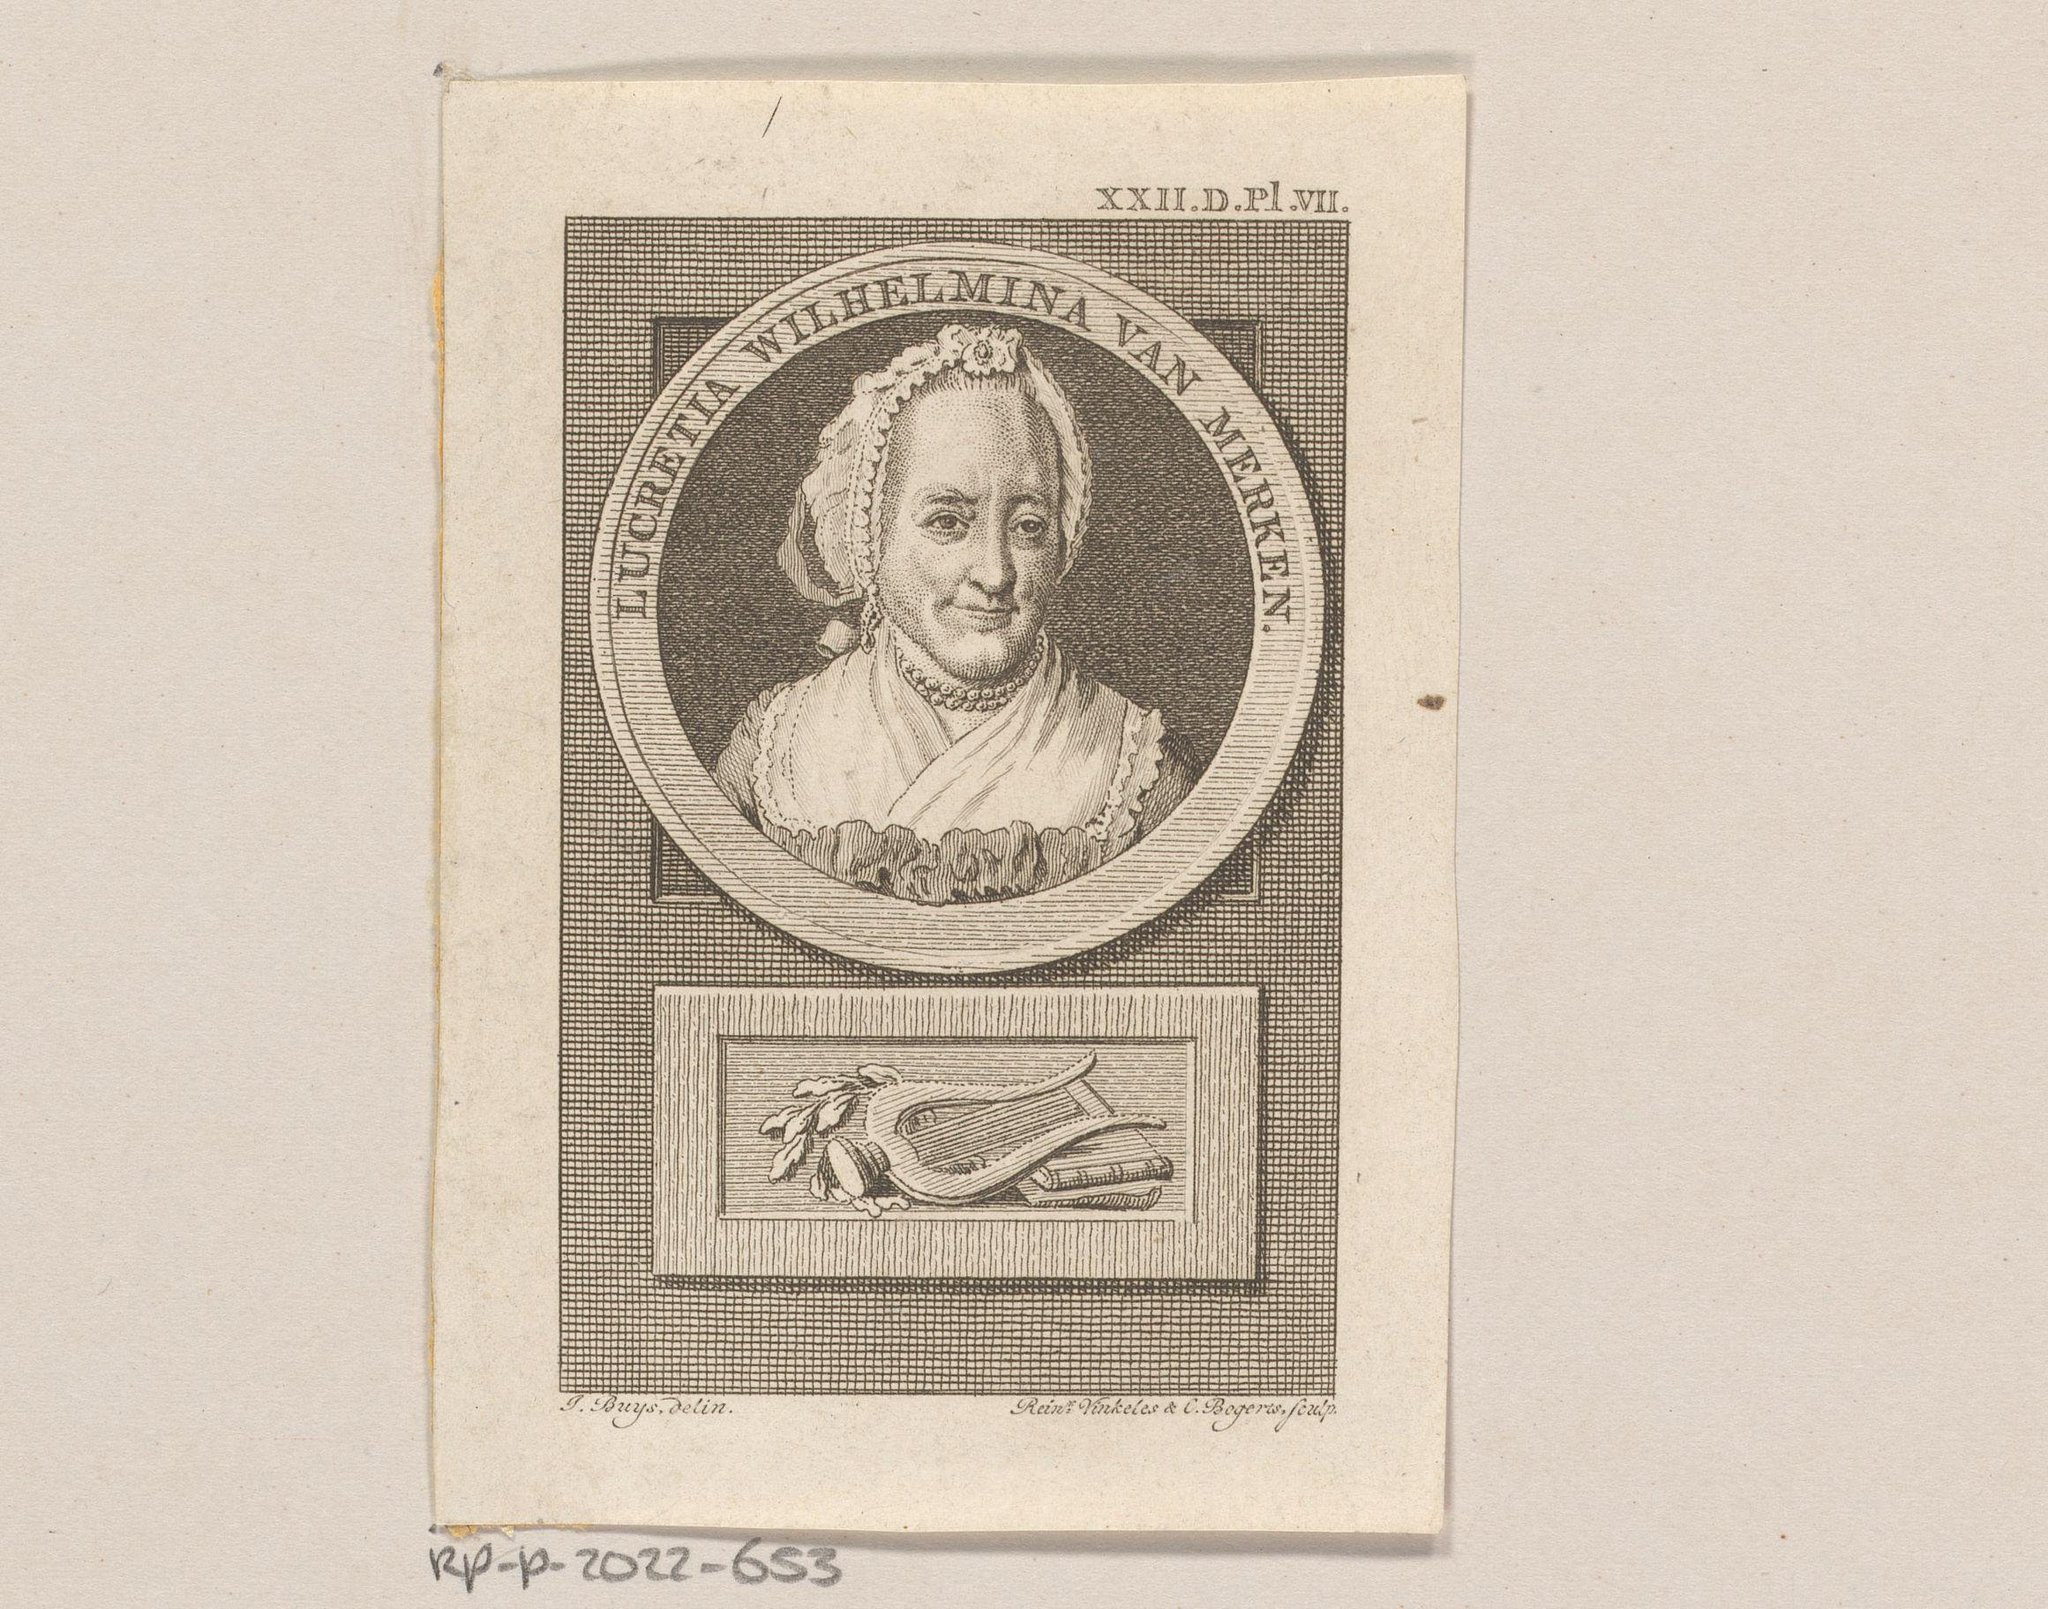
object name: print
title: Portret van Lucretia Wilhelmina van Merken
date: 1794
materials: paper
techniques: engraving, etching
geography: amsterdam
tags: leiden, lucretia wilhelmina van merken, historical persons - bb - woman, portrait of a writer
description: Prent waarschijnlijk uit: Fokke, Jan. Geschiedenissen der Vereenigde Nederlanden voor de vaderlandsche jeugd (...). Amsterdam: Johannes Allart, 1794, dl. 22.